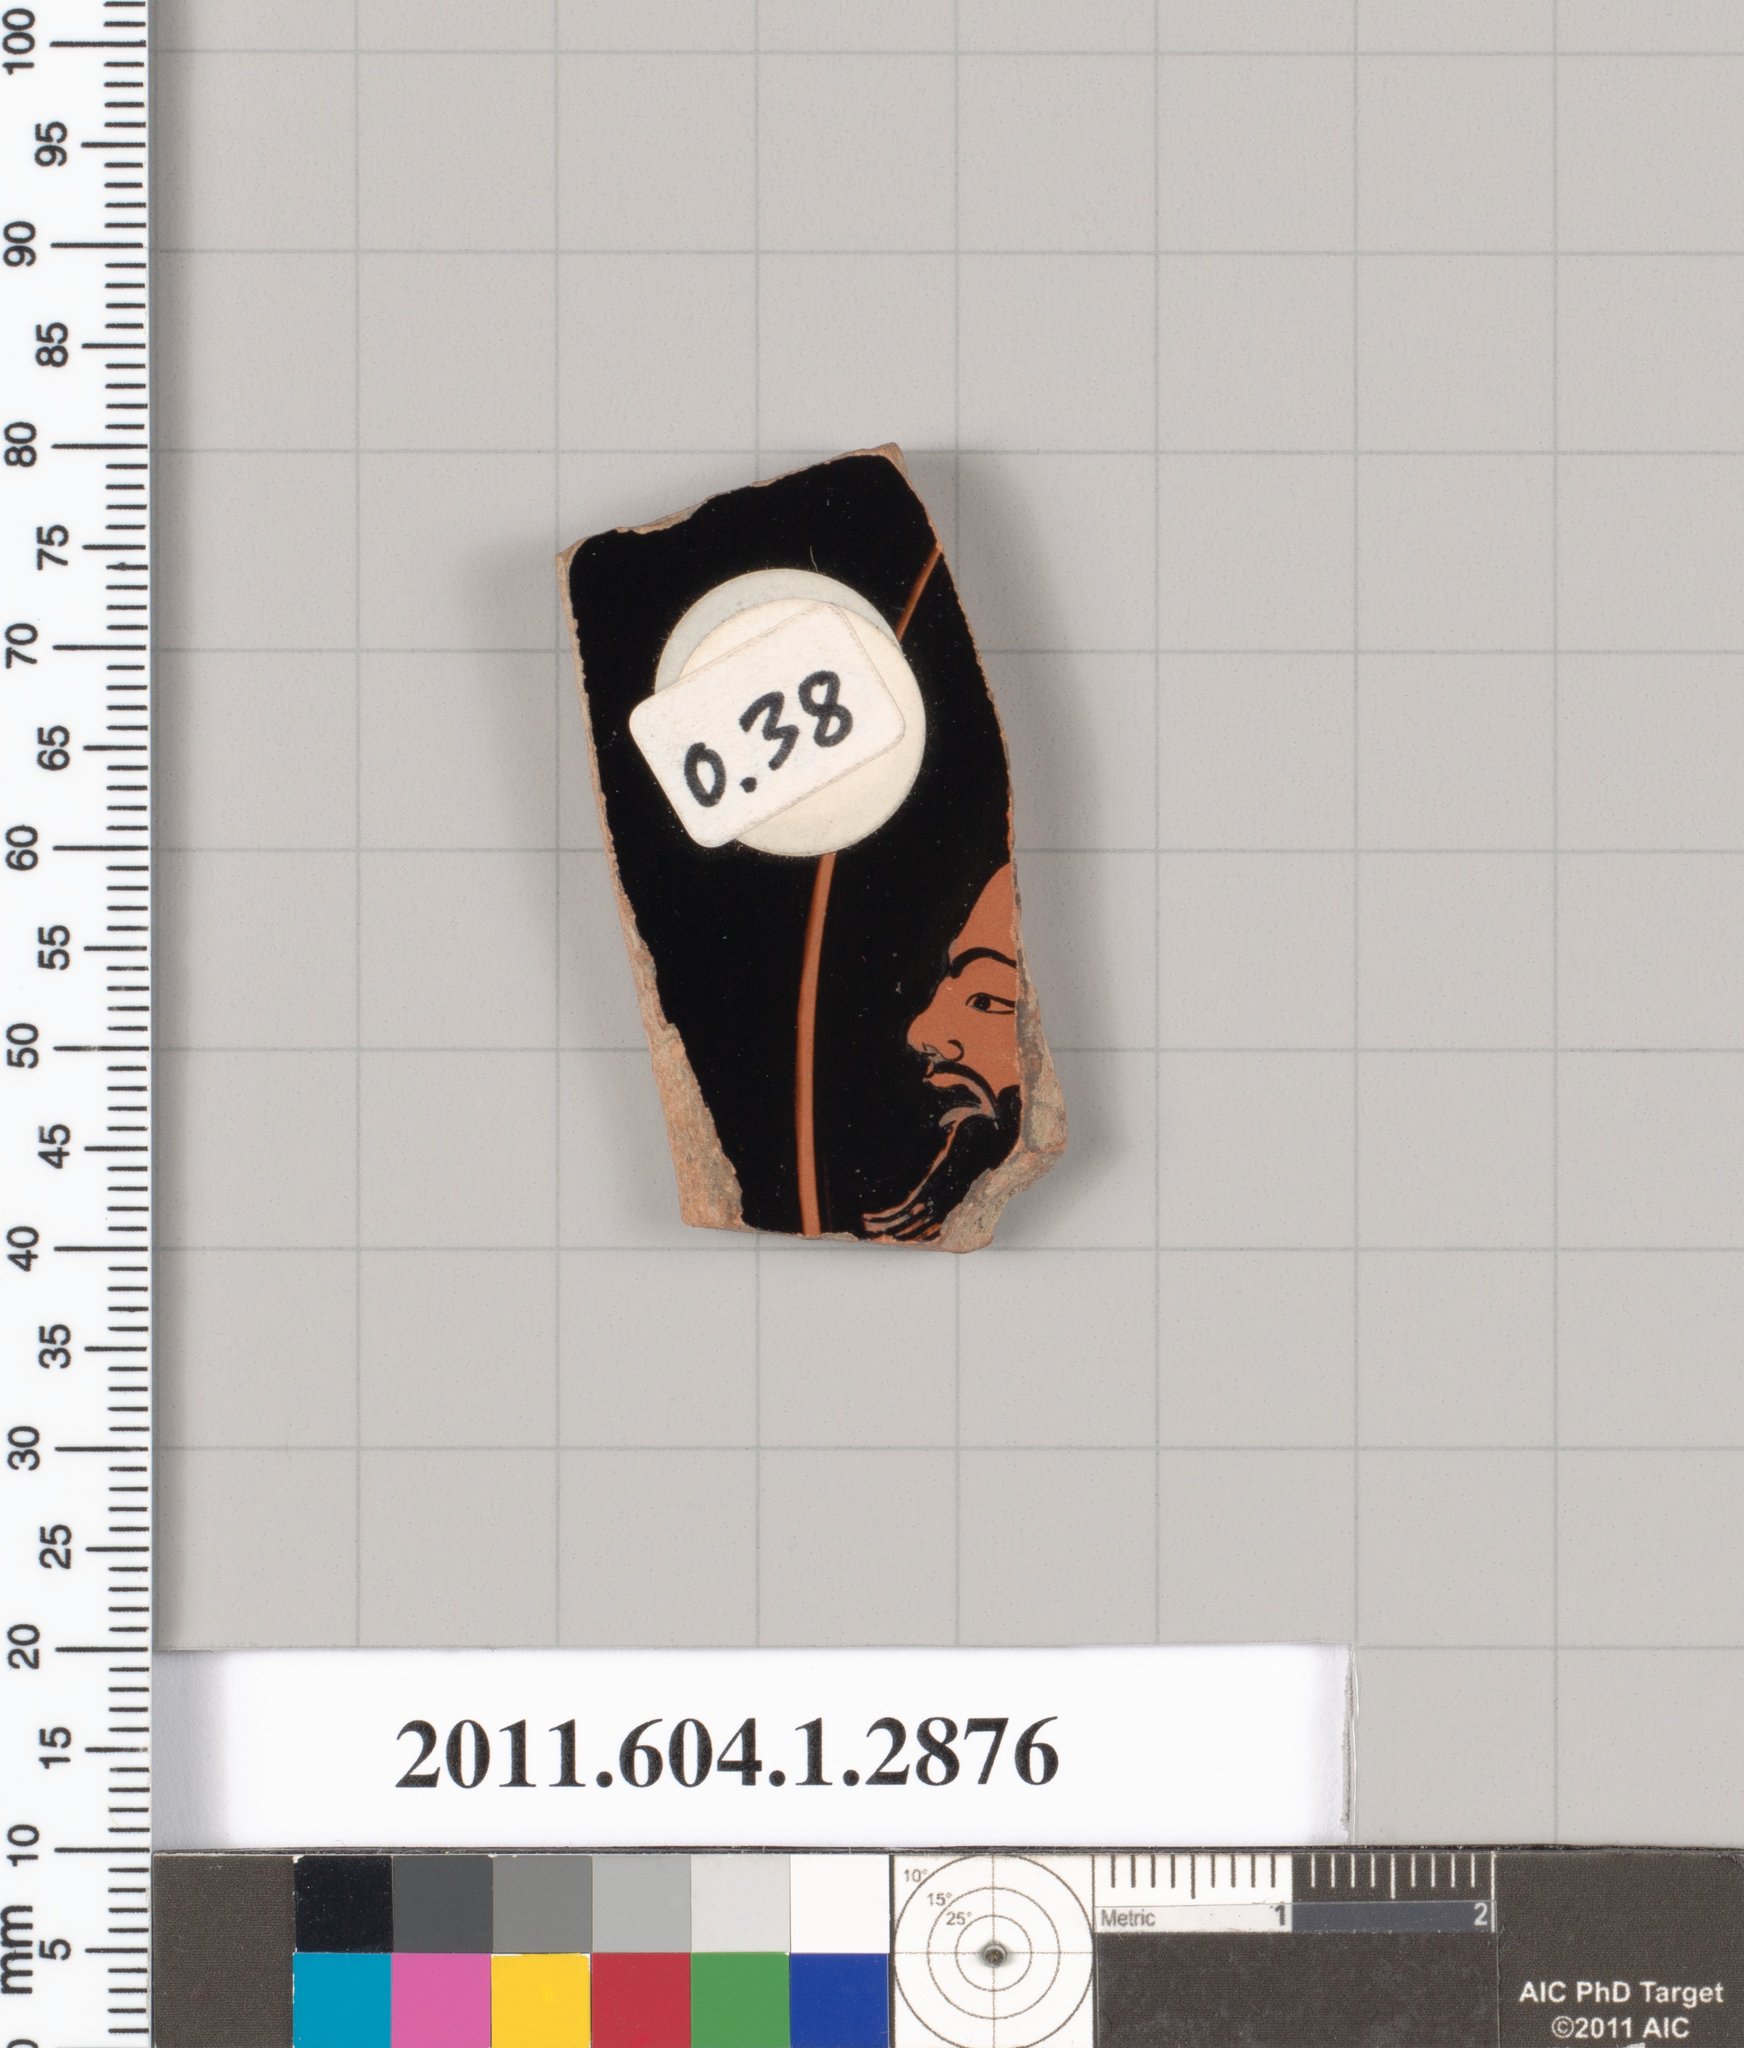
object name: kylix fragment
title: Terracotta fragment of a kylix (drinking cup)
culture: greek, attic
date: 500-480 BCE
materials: terracotta